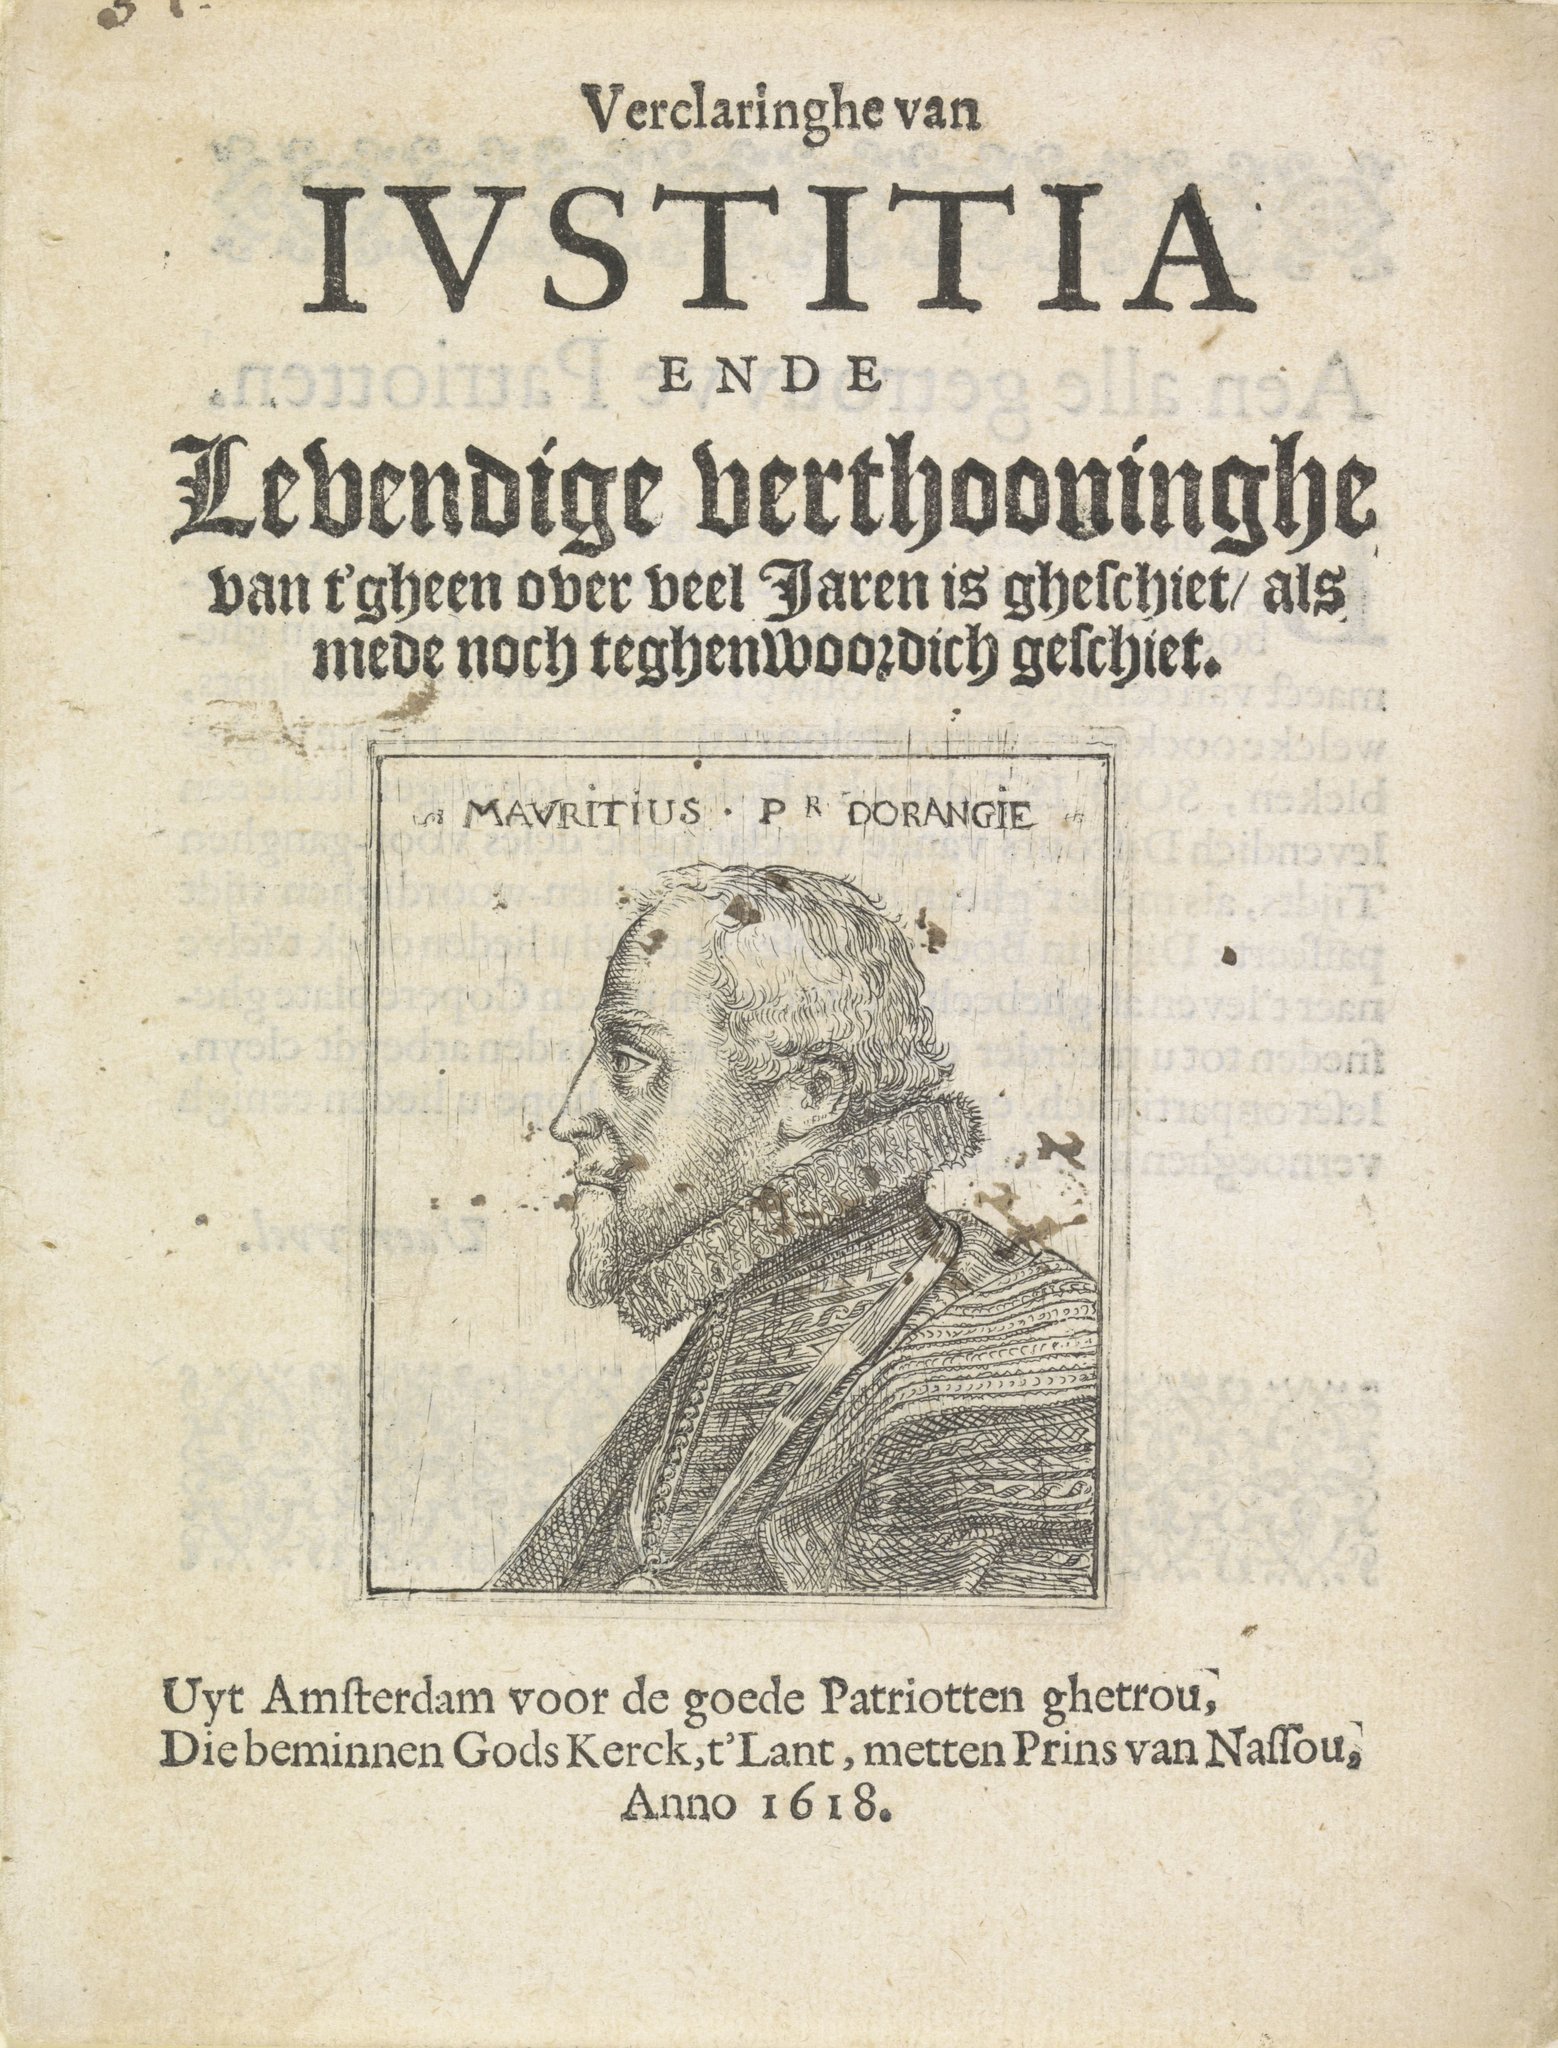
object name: print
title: Portret van Maurits, prins van Oranje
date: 1618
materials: paper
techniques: etching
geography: amsterdam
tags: the hague, maurice (prince of orange), knighthood order (garter) - insignia of a knighthood order, e.g.: badge, chain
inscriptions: collector's mark: Lugt 2228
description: De hier vermelde titel verwijst naar de hoogst verkregen titel van de geportretteerde, niet per se naar de titel die de geportretteerde op deze voorstelling draagt. Prent uit: Verclaringhe van ivstitia ende levendige verthooninghe van t'gheen over veel iaren is gheschiet, als mede noch thegenwoordich geschiet. Amsterdam, 1618.